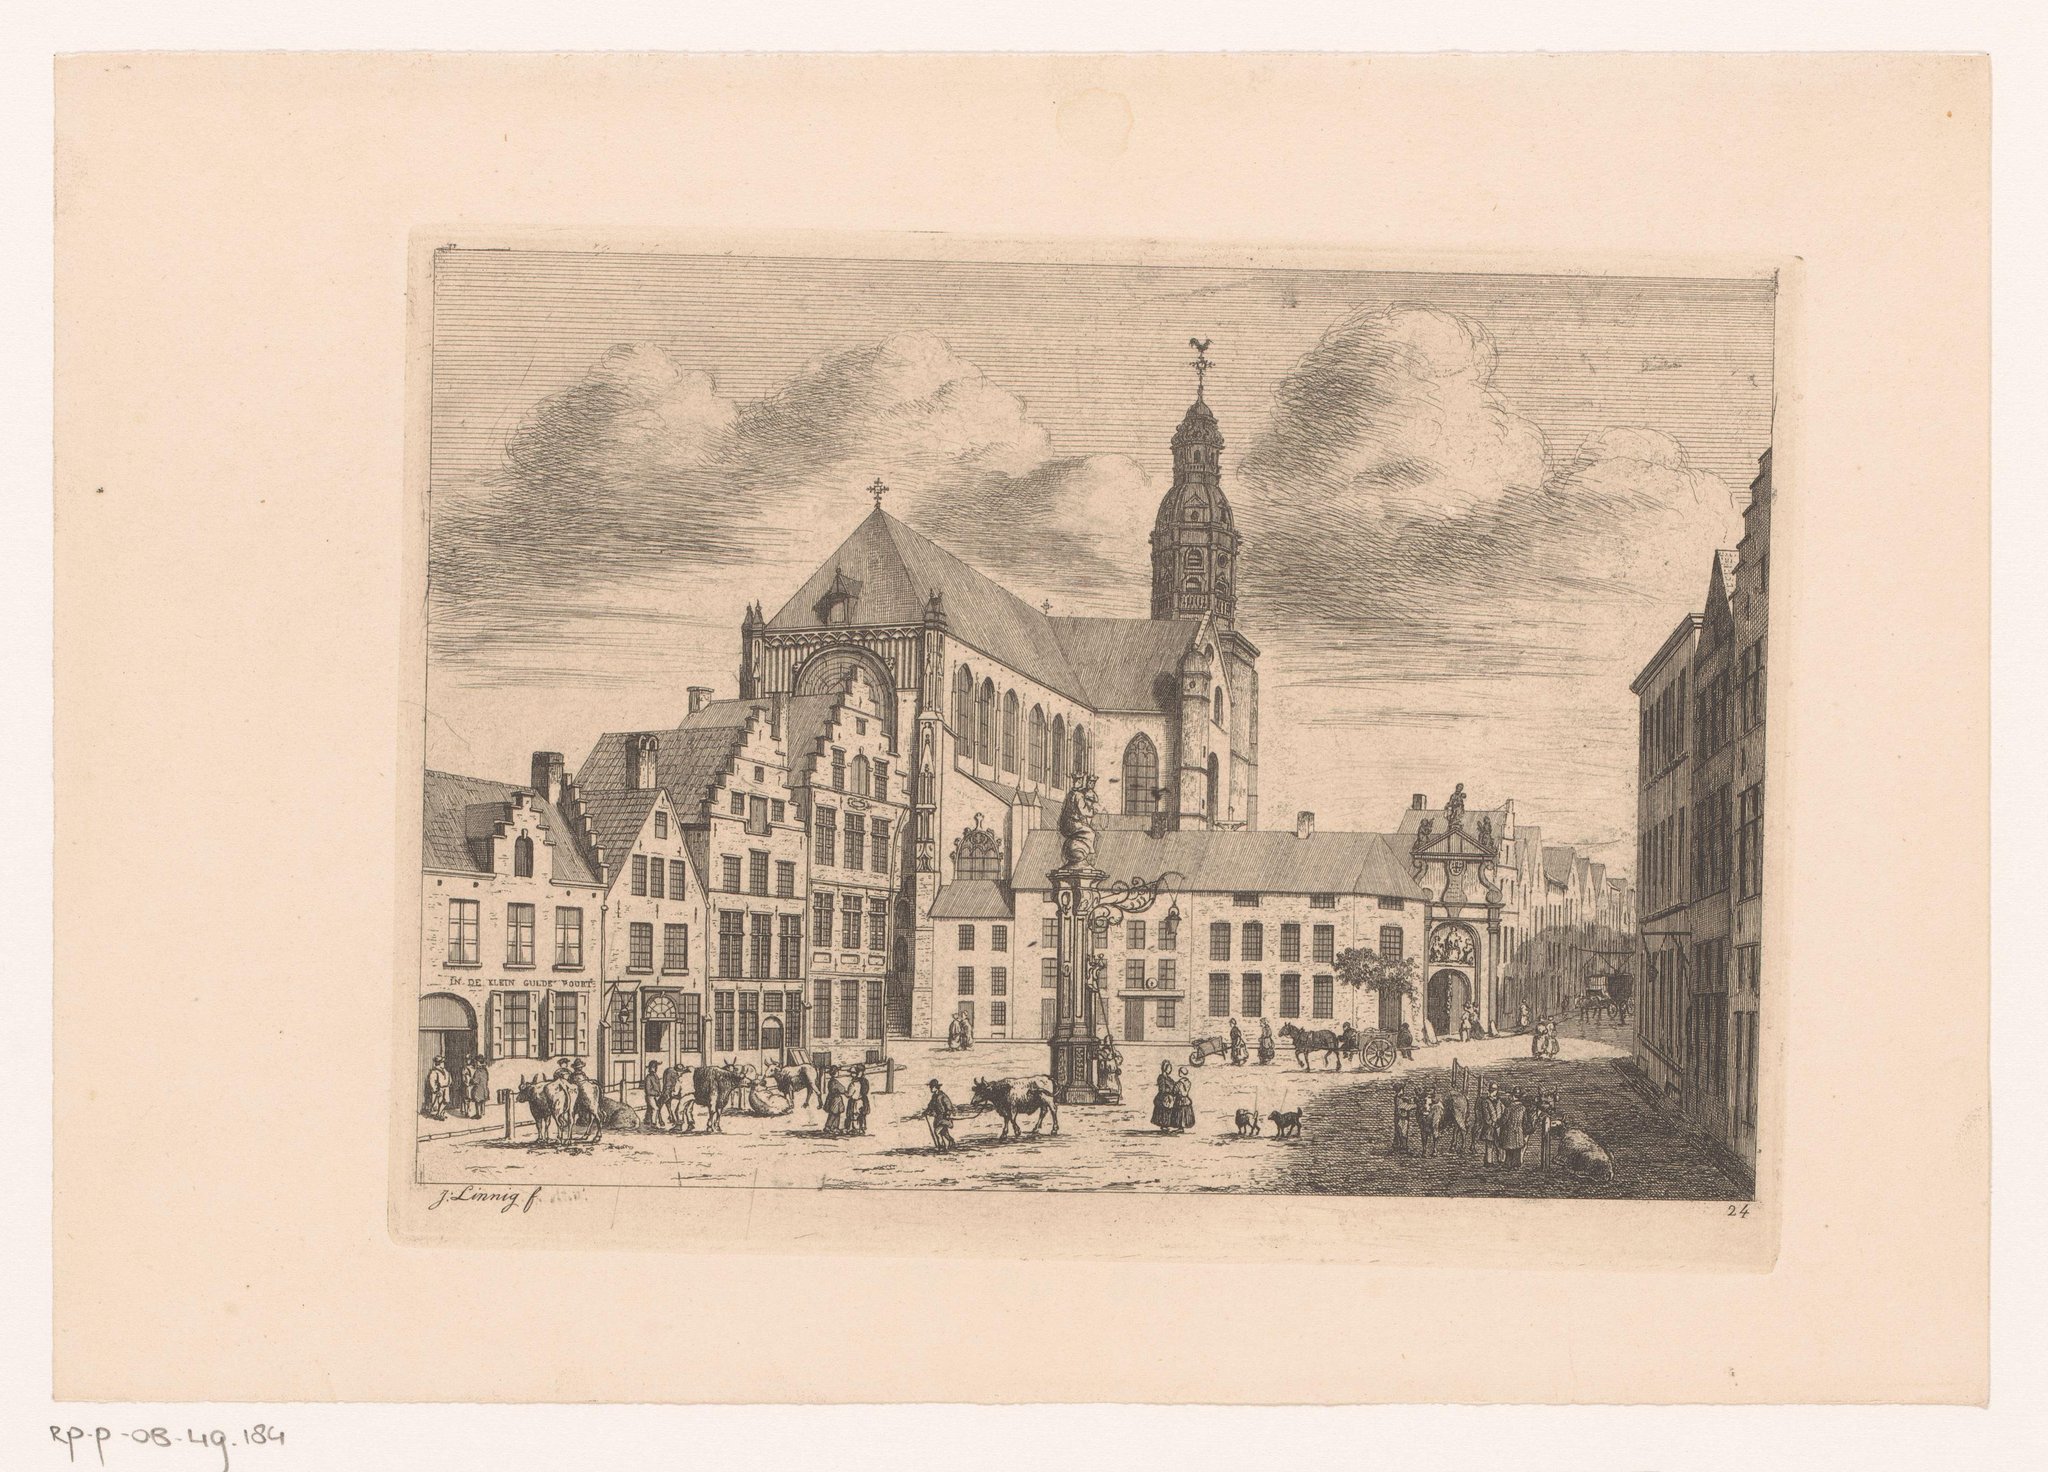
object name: book illustration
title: Gezicht op de Veemarkt in Antwerpen met de Sint-Pauluskerk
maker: jean théodore joseph linnig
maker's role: draughtsman, print maker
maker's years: 1815-1891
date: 1868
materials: paper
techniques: etching, intaglio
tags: square, place, circus, etc., church (exterior), utilitarian, public pump or water fountain, antwerp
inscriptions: collector's mark: Lugt 2228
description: Prent uit: Mertens, F.H. Album historique de la ville d'Anvers [...]. Antwerpen: J.E. Buschmann, 1868.